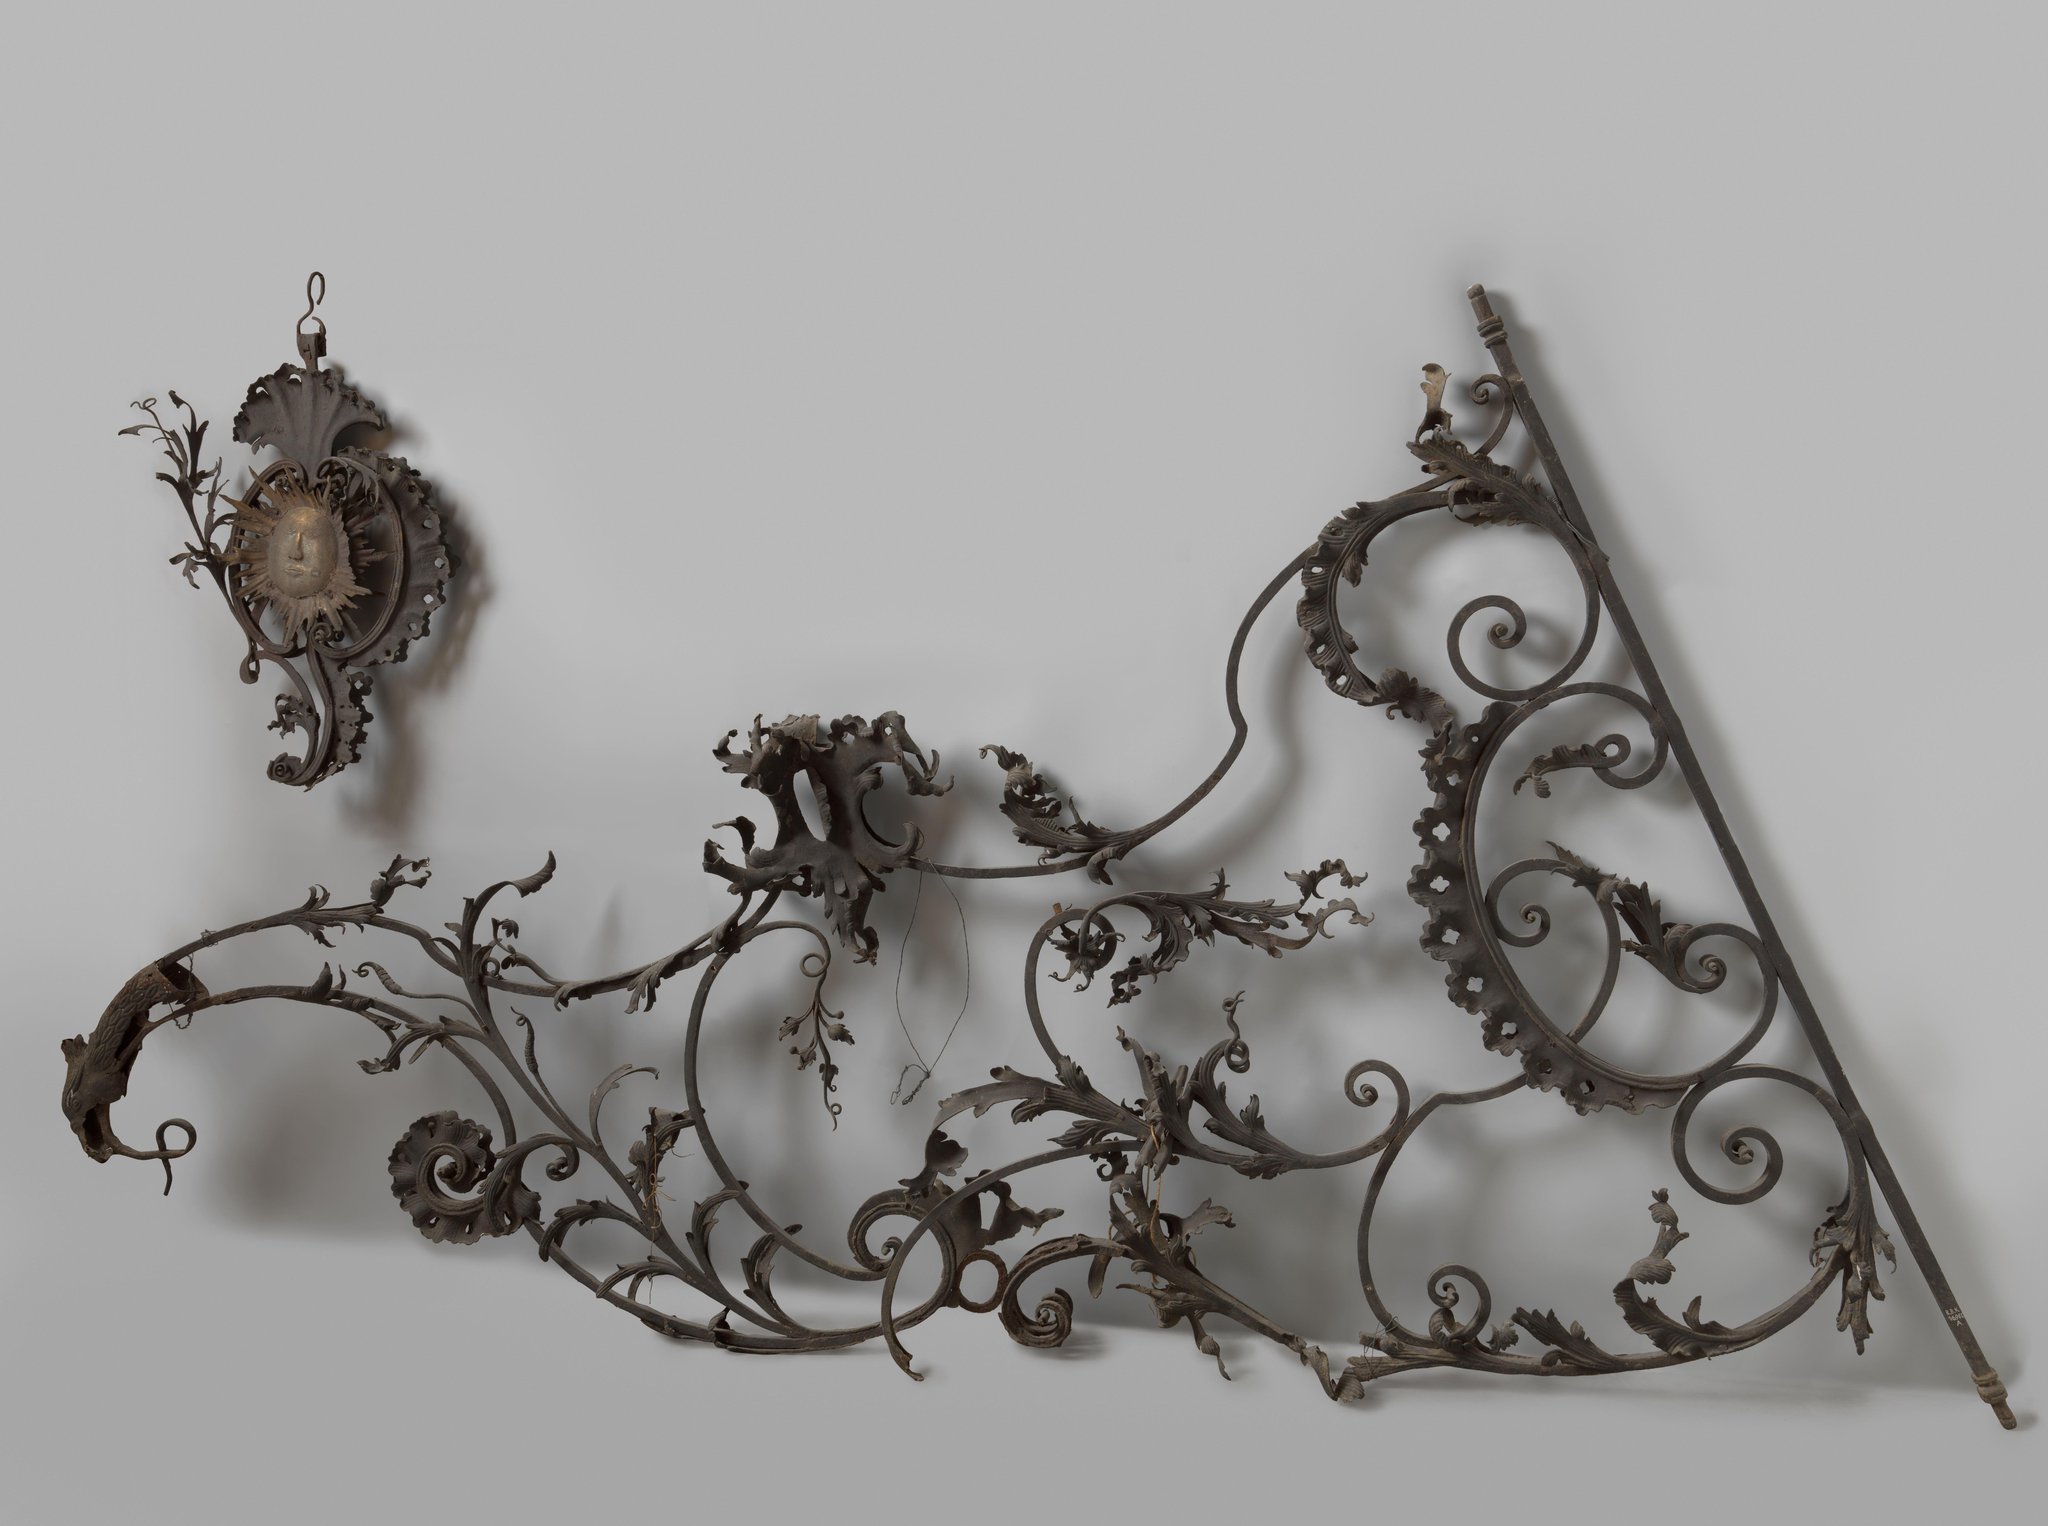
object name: uithangarm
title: Uithangarm, versierd met in vogelkop eindigende voluten. Verz. Mannheimer.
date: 1760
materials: iron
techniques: gilding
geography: austria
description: Een ijzeren uithangarm bestaande uit vierkante staven die gevormd zijn tot C- en gebroken S-voluten, Aan de arm die in een vogelkop eindigt, hangt een schild met een verguld zon. De voluten van de arm dragen enig bladwerk en een grote bebladerde rank. Bij het schild omsluiten C-voluten het gelaat van de zon, waaromheen stralen zijn aangebracht. Enige dezer voluten hebben een geschulpte bladrand. Afkomstig uit de verzameling Dr. F. Mannheimer.